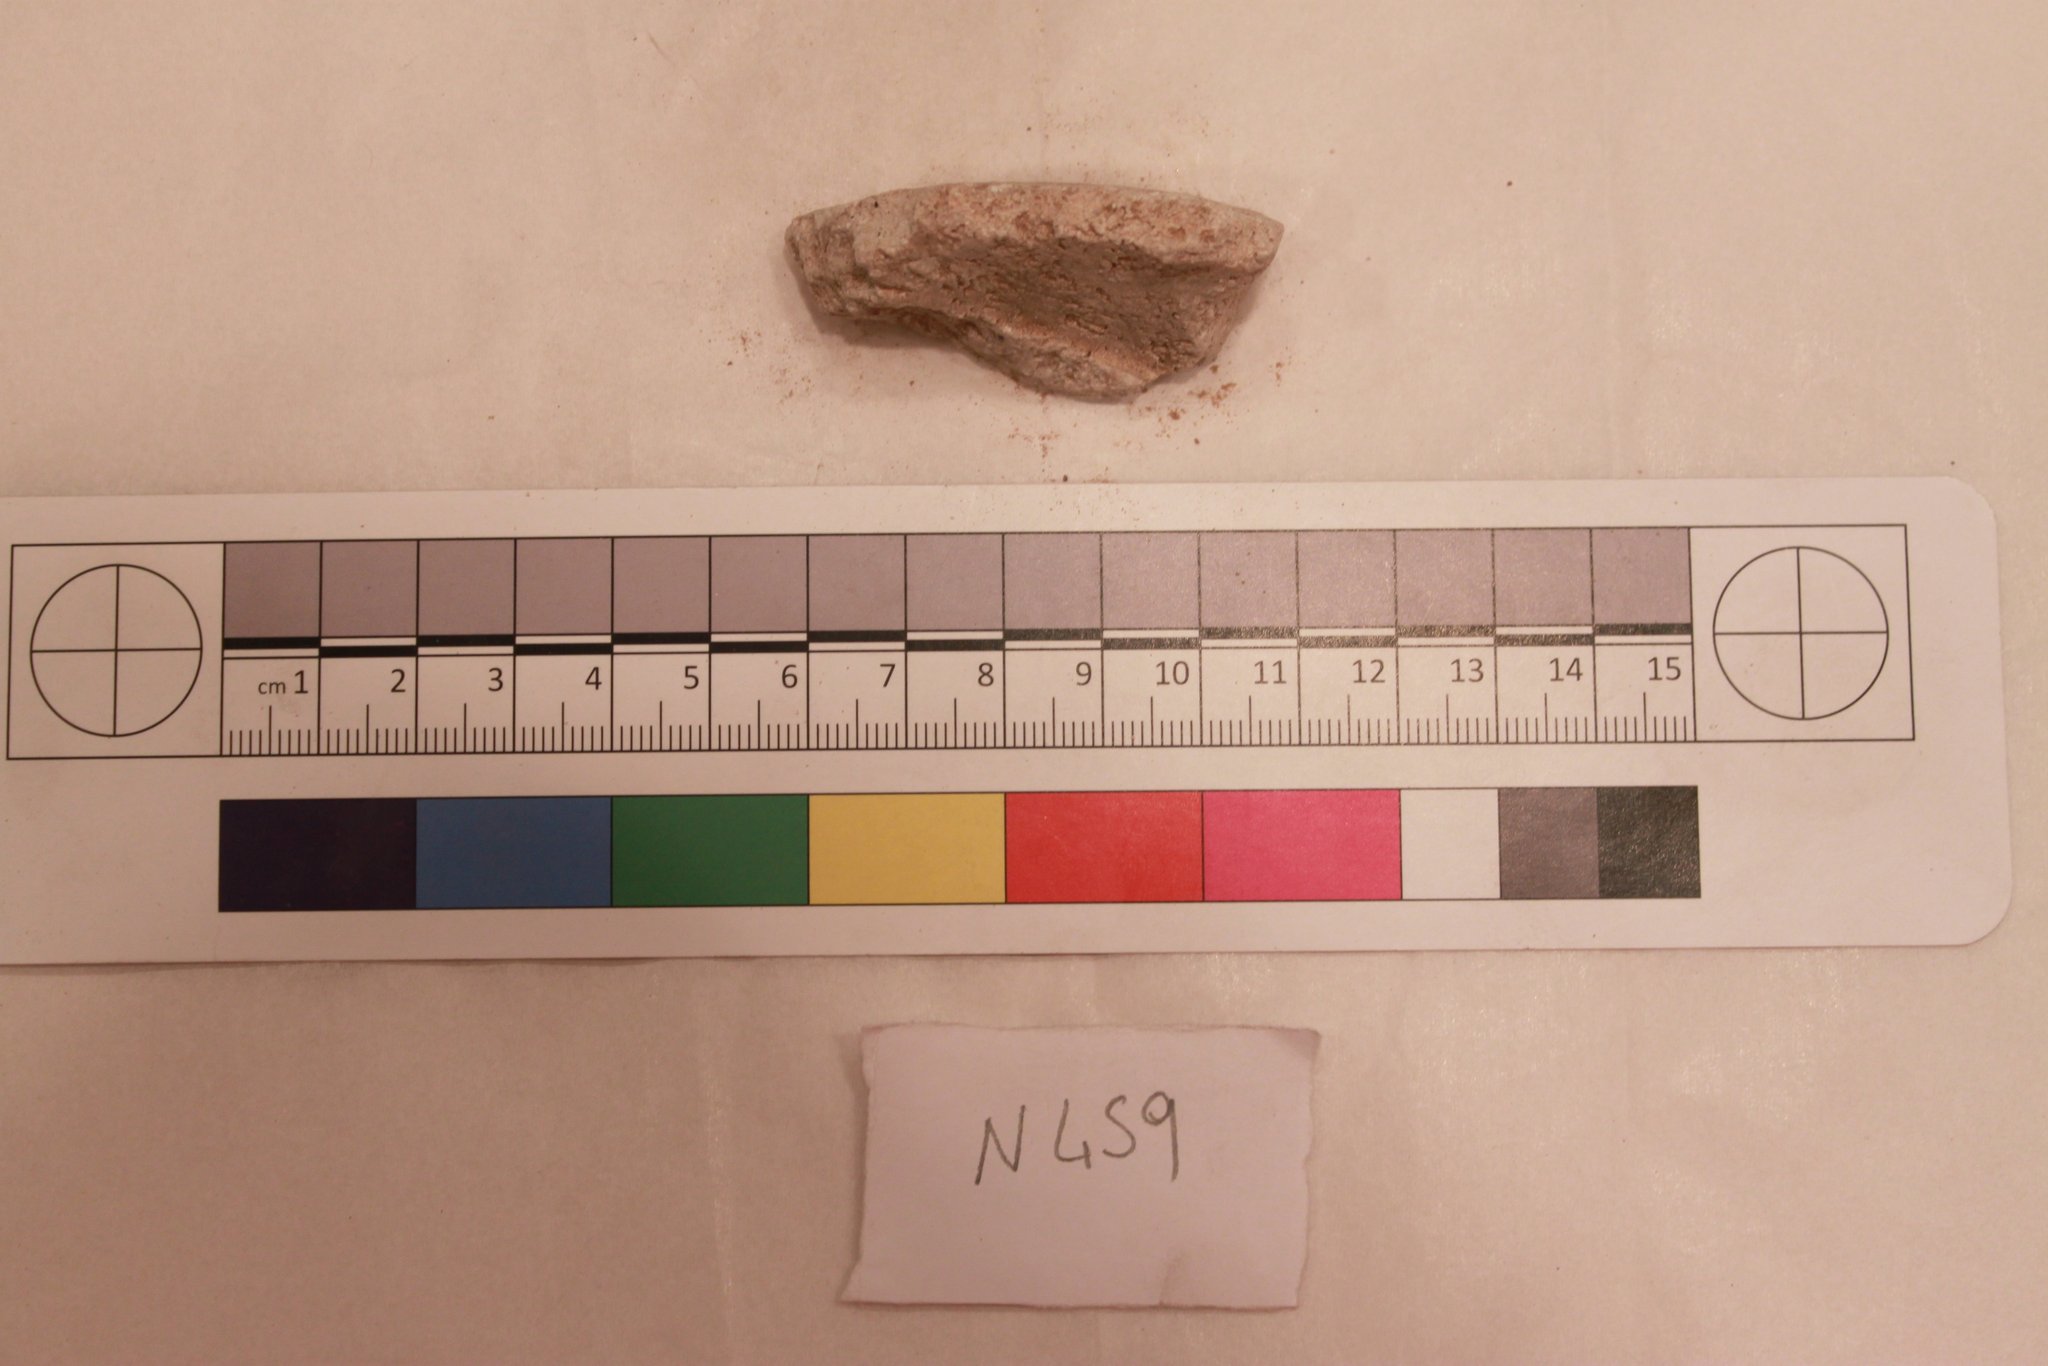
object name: fragment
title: Stucco Fragment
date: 701-1200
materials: plaster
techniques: carving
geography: iran